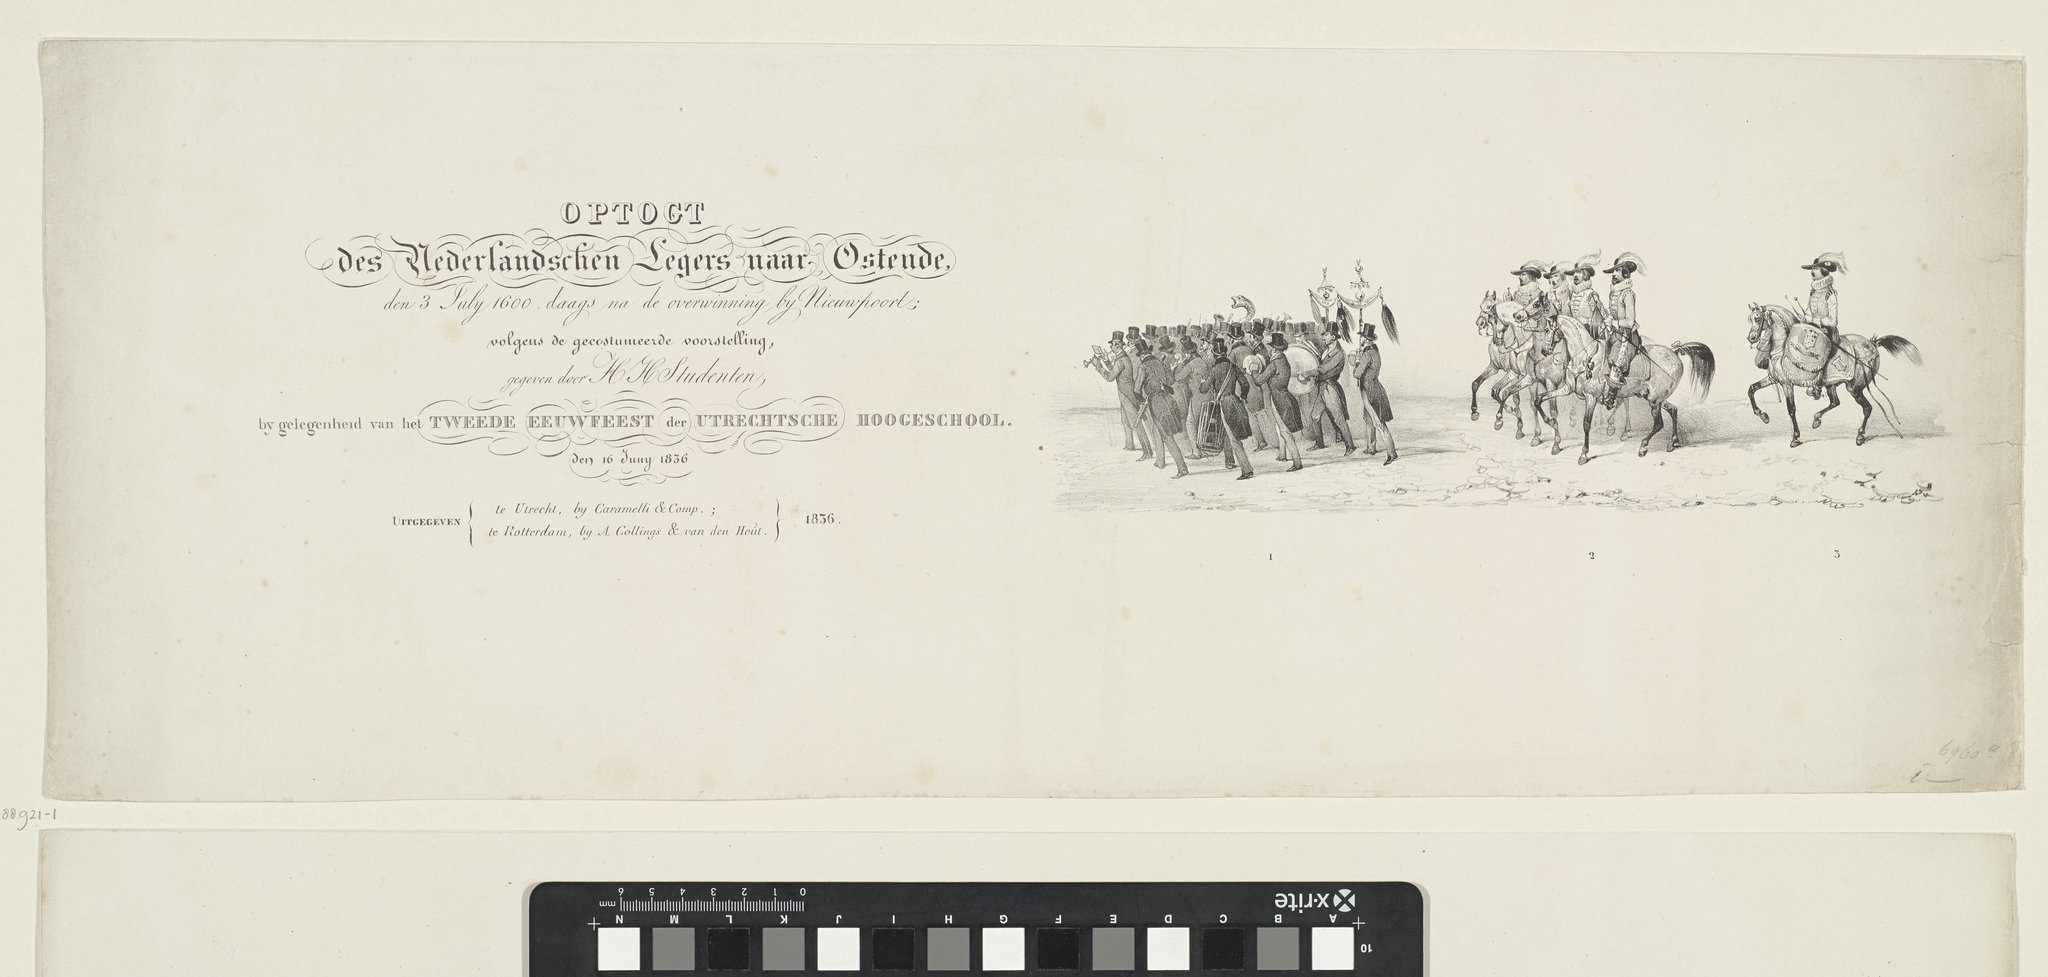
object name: titelprent, frontispice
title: Optogt des Nederlandschen Legers naar Ostende, den 3 July 1600, daags na de overwinning by Nieuwpoort; volgens de gecostumeerde voorstelling, gegeven door H H Studenten, by gelegenheid van het Tweede Eeuwfeest der Utrechtsche Hoogeschool. den 16 Juny 1836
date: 1837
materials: paper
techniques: lithograph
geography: paris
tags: students' pageant, costumes used in pageants, battle of nieuwpoort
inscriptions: collector's mark: Lugt 2228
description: Historische gekostumeerde optocht van de studenten van de Hogeschool van Utrecht op 16 juni 1836, bij de viering van het tweede eeuwfeest van de Utrechtse Hogeschool. De optocht verbeeldt de intocht van het Staatse leger in Oostende op 3 juli 1600, daags na de overwinning in de Slag bij Nieuwpoort. De stoet voorafgegaan door een muziekkorps. Eerste plaat in een serie van tien ongenummerde platen, met de titel en de groepen genummerd 1-3.